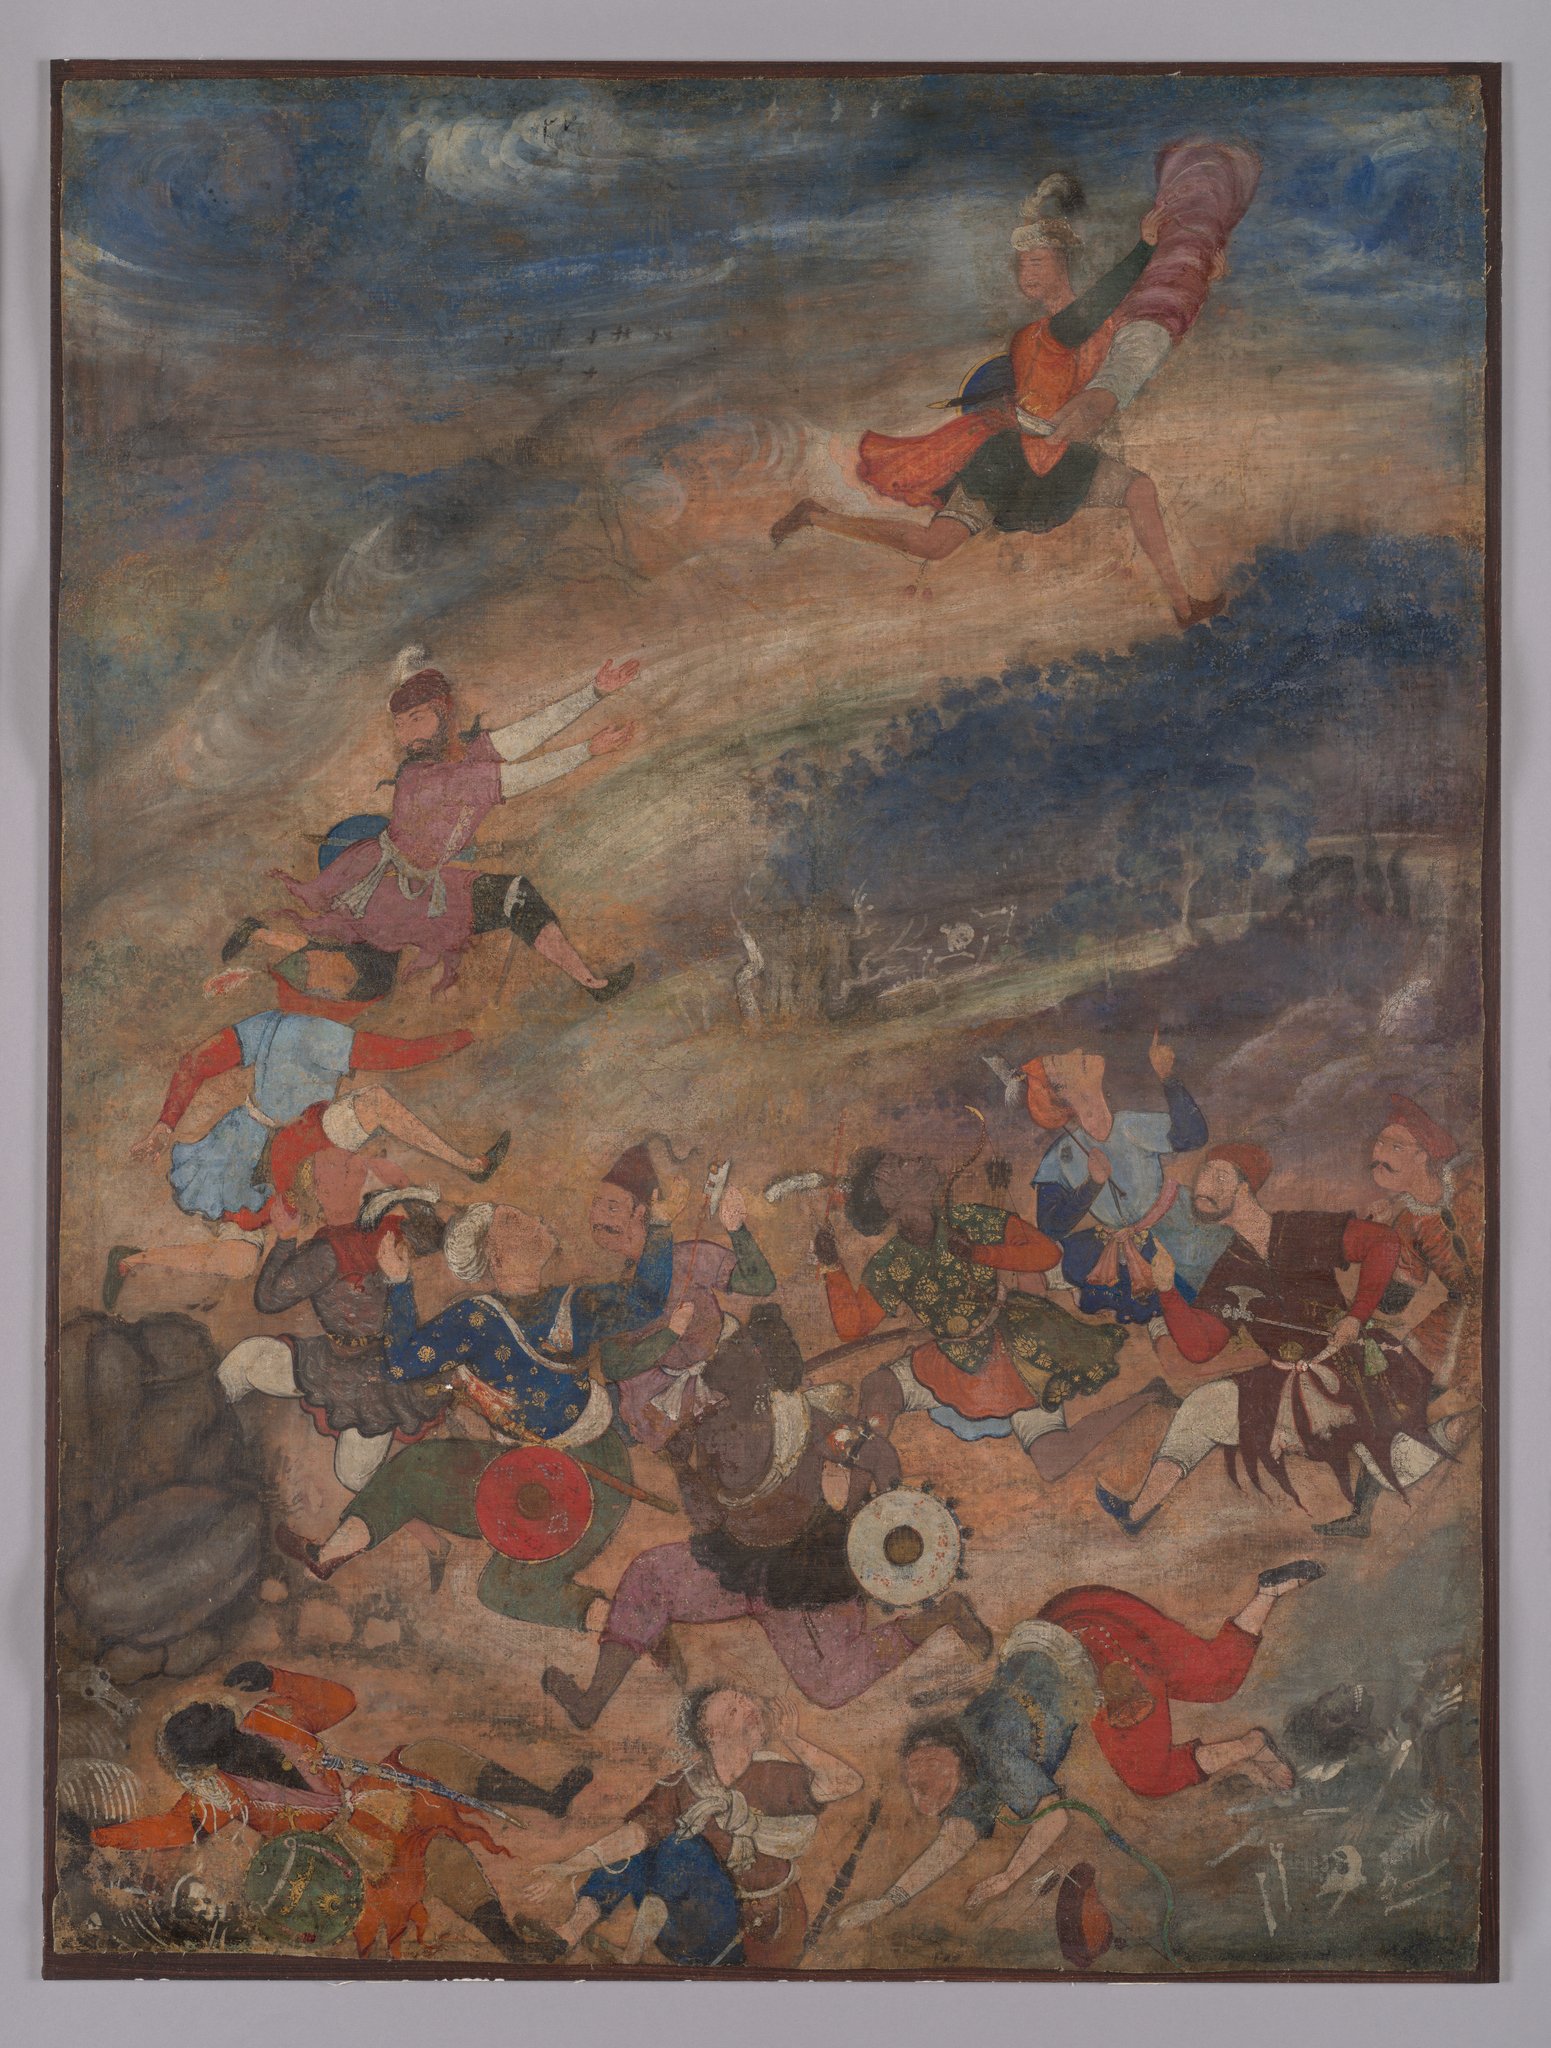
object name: folio from an illustrated manuscript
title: "Khwaja Umar Saved from Pursuers," Folio from the Hamzanama (The Adventures of Hamza)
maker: kesu das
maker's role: artist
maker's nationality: indian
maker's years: 1545-1627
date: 1565-1570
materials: textile, cotton, gold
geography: india